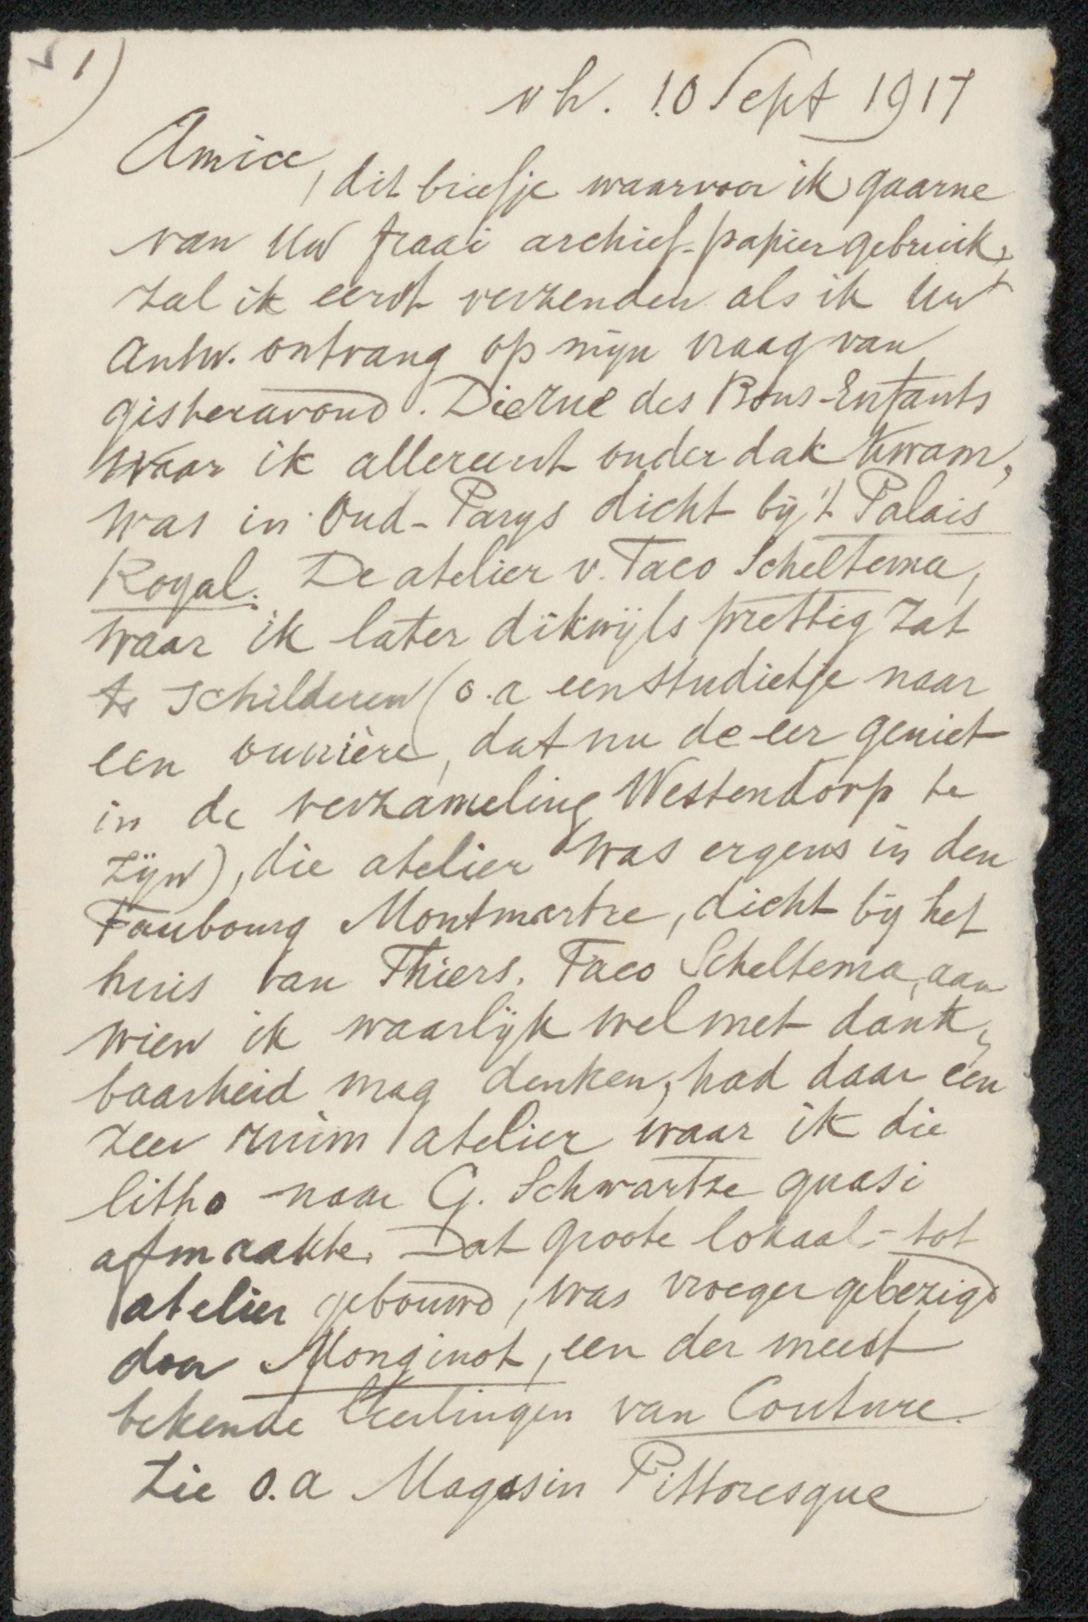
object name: letter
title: Brief aan Jan Veth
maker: august allebé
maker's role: draughtsman, print maker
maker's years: 1838-1927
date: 1917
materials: ink, paper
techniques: pen, writing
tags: marseille, politician, johann georg schwartze, dordrecht, painter, designer, jan veth, arnhem, taco jan scheltema, herman karel westendorp, haarlem, louis van erven dorens, charles monginot, paris, the graphic arts, painting (including book-illumination, miniature-painting), workshop, studio of the artist (in general), historical persons (portraits and scenes from the life)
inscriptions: collector's mark: ‘RPK’